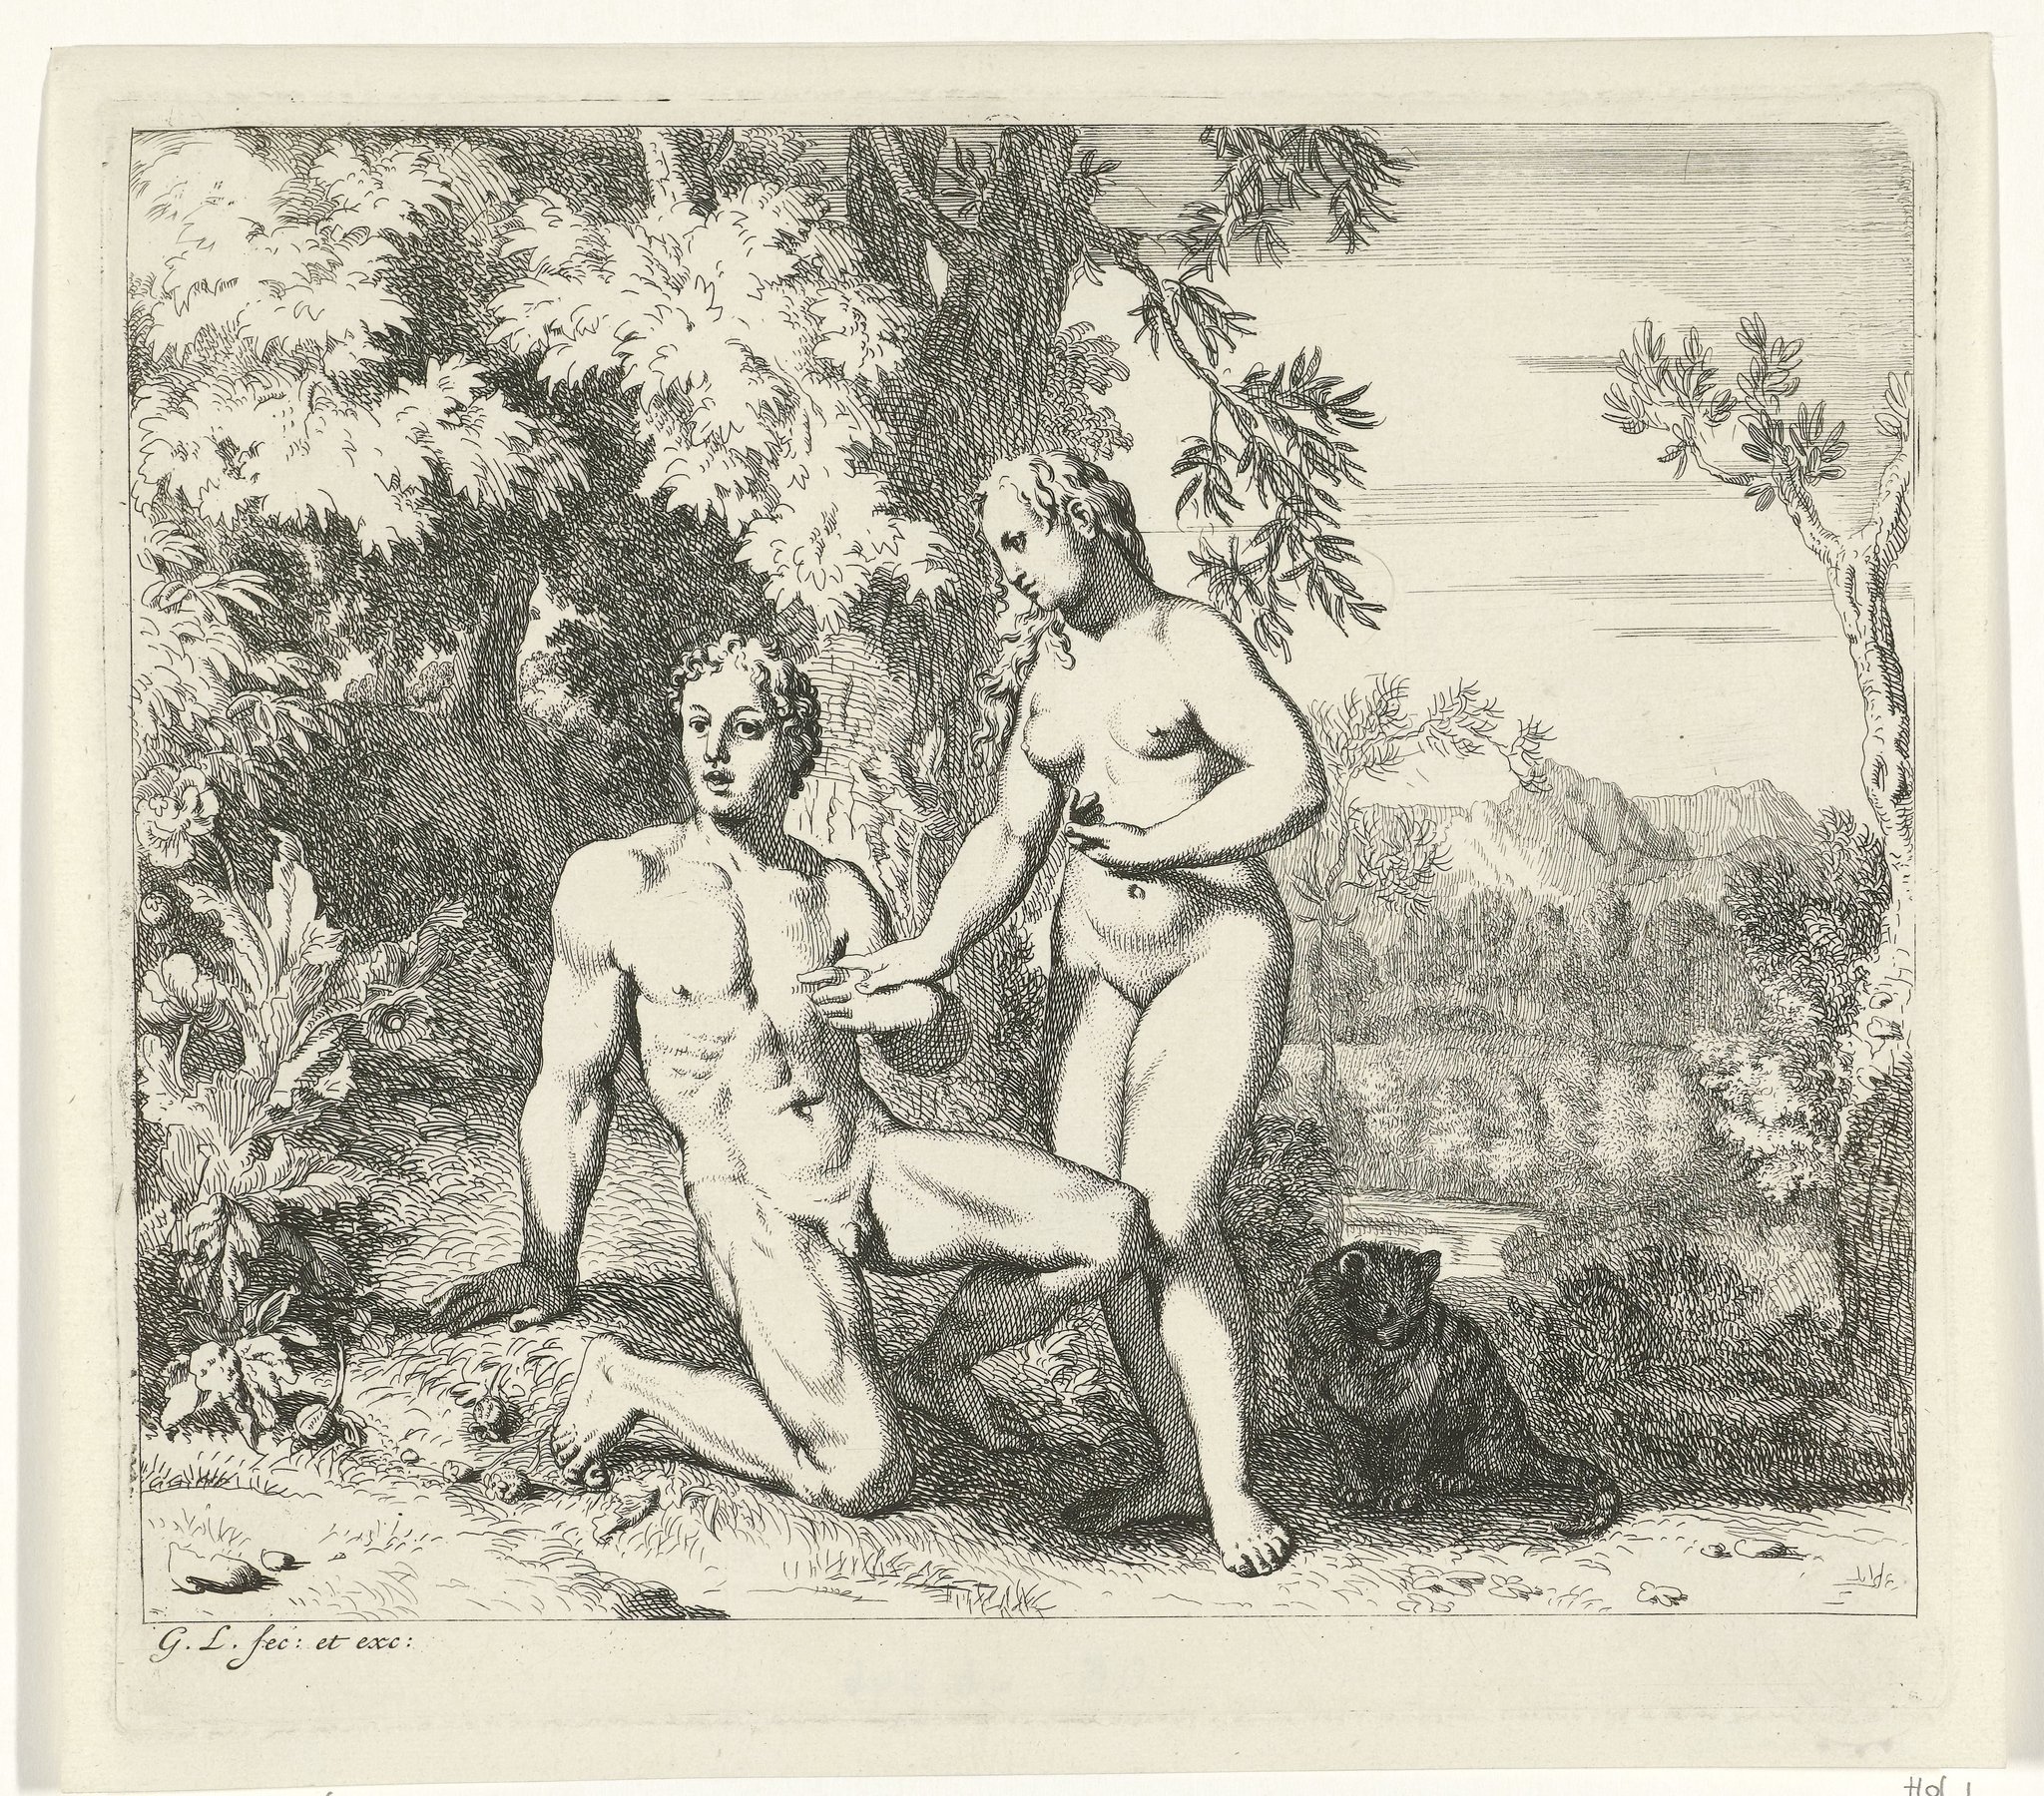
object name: print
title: Adam en Eva in het paradijs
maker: gerard de lairesse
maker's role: draughtsman, painter, print maker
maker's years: 1641-1711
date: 1665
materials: paper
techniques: etching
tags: adam and eve in paradise (before the fall)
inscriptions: collector's mark: Lugt 240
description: Adam en Eva, naakt in het paradijs. Adam houdt Eva's hand vast en probeert op te staan vlak nadat hij door God geschapen is. Achter Eva zit een kat. De prent maakt deel uit van een zevendelige serie met scènes uit het Bijbelboek Genesis.